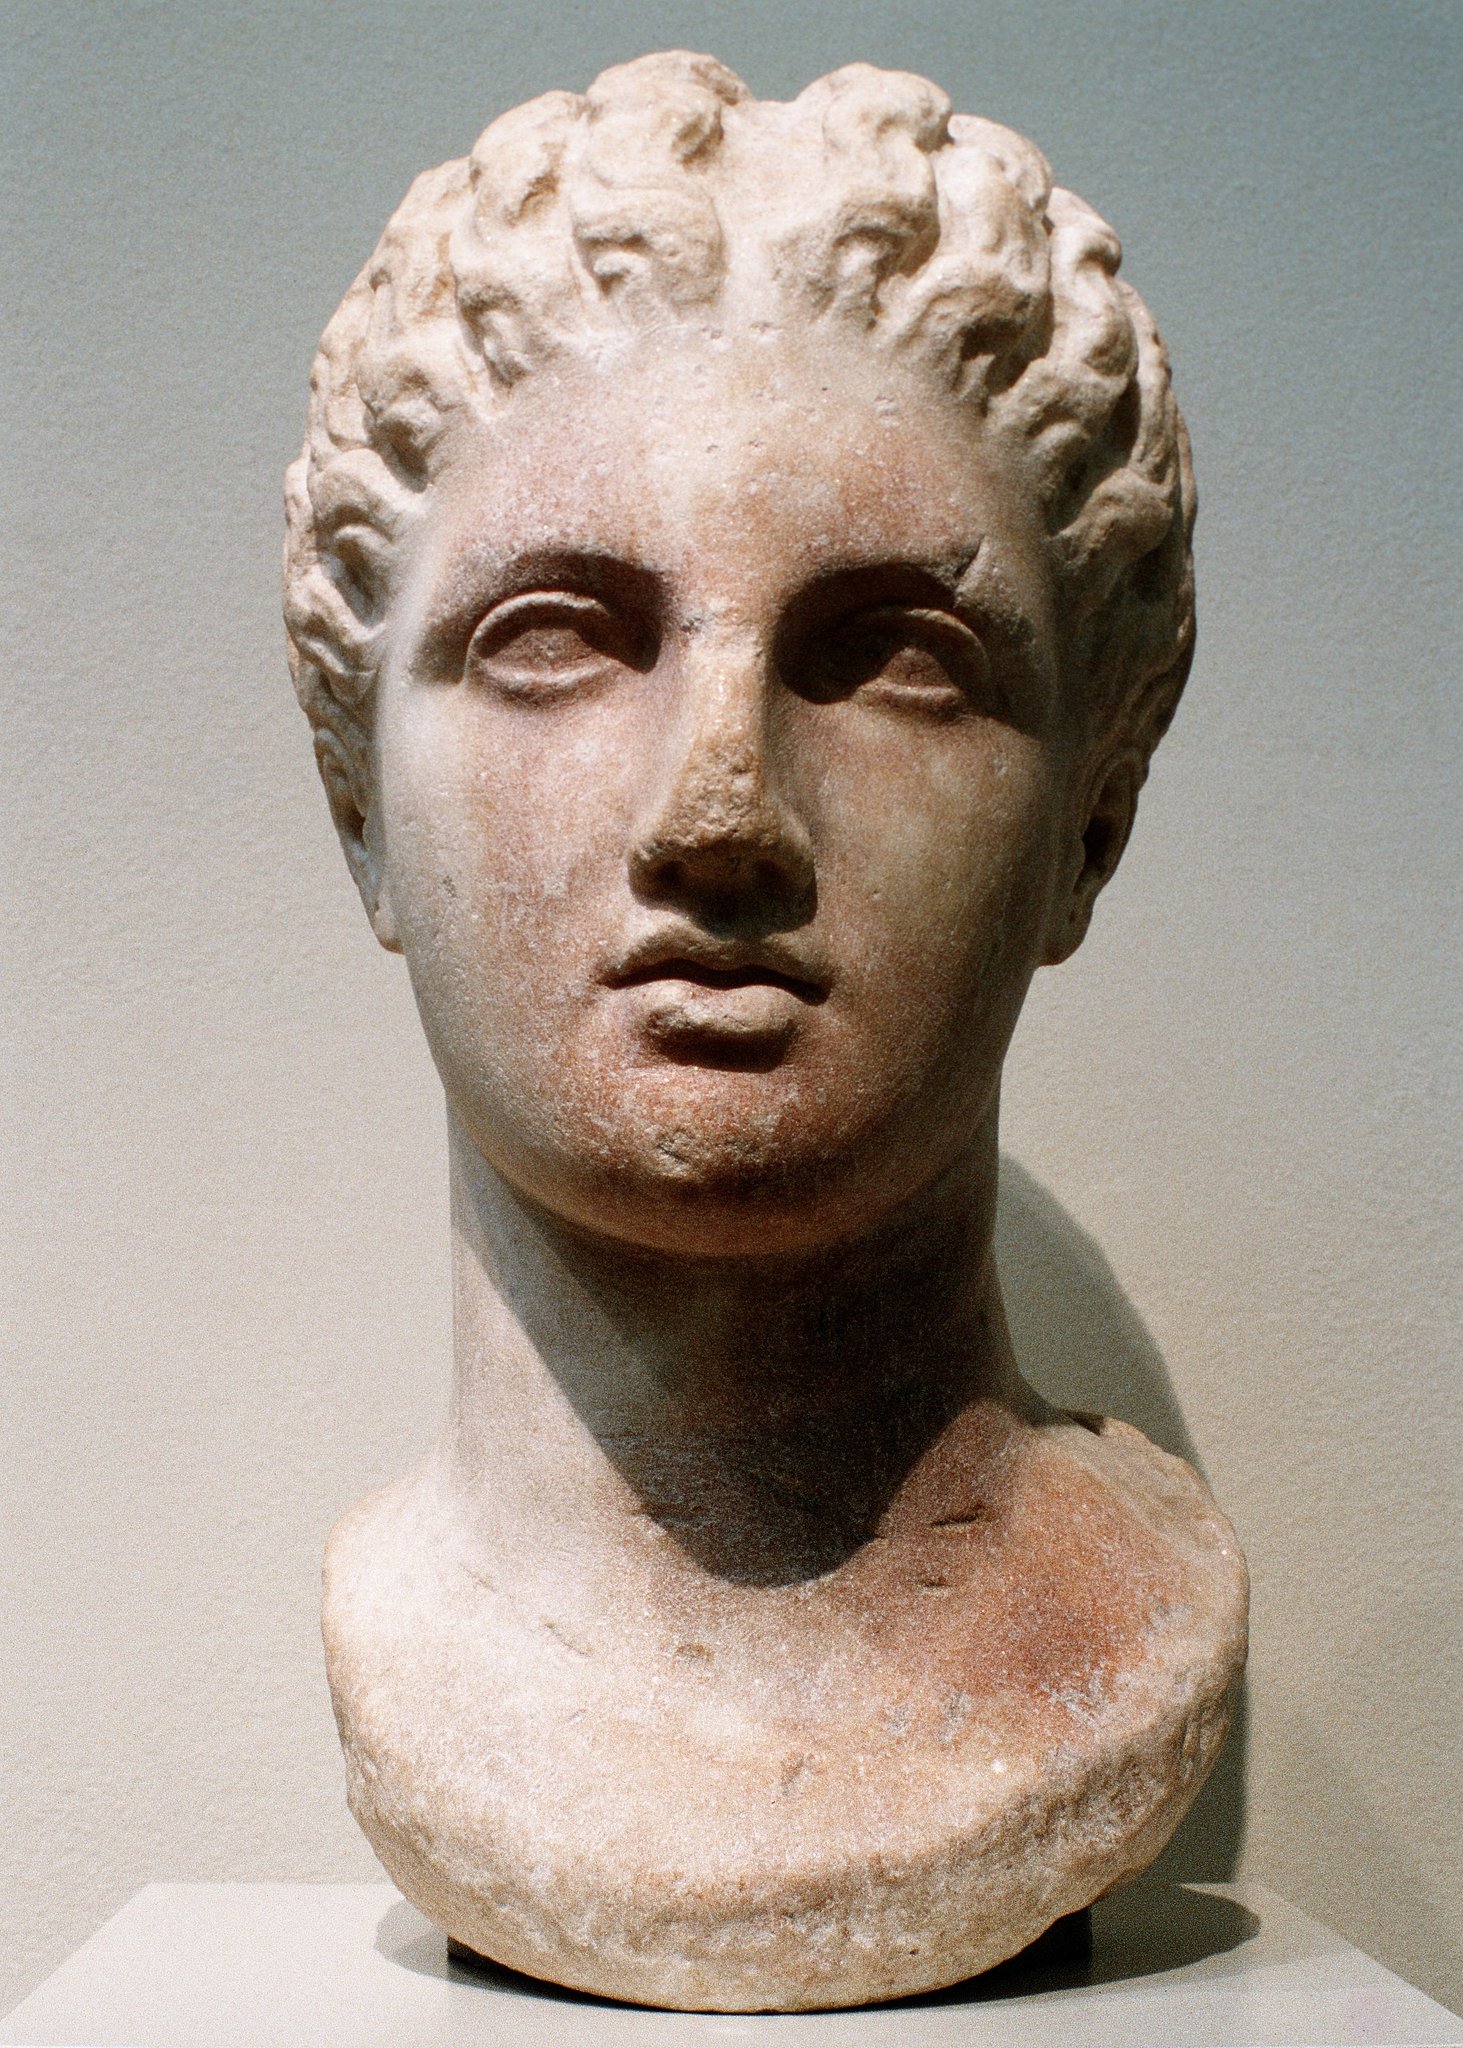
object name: head of a goddess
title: Marble head of a goddess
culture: greek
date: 400-301 BCE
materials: marble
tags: heads,goddess